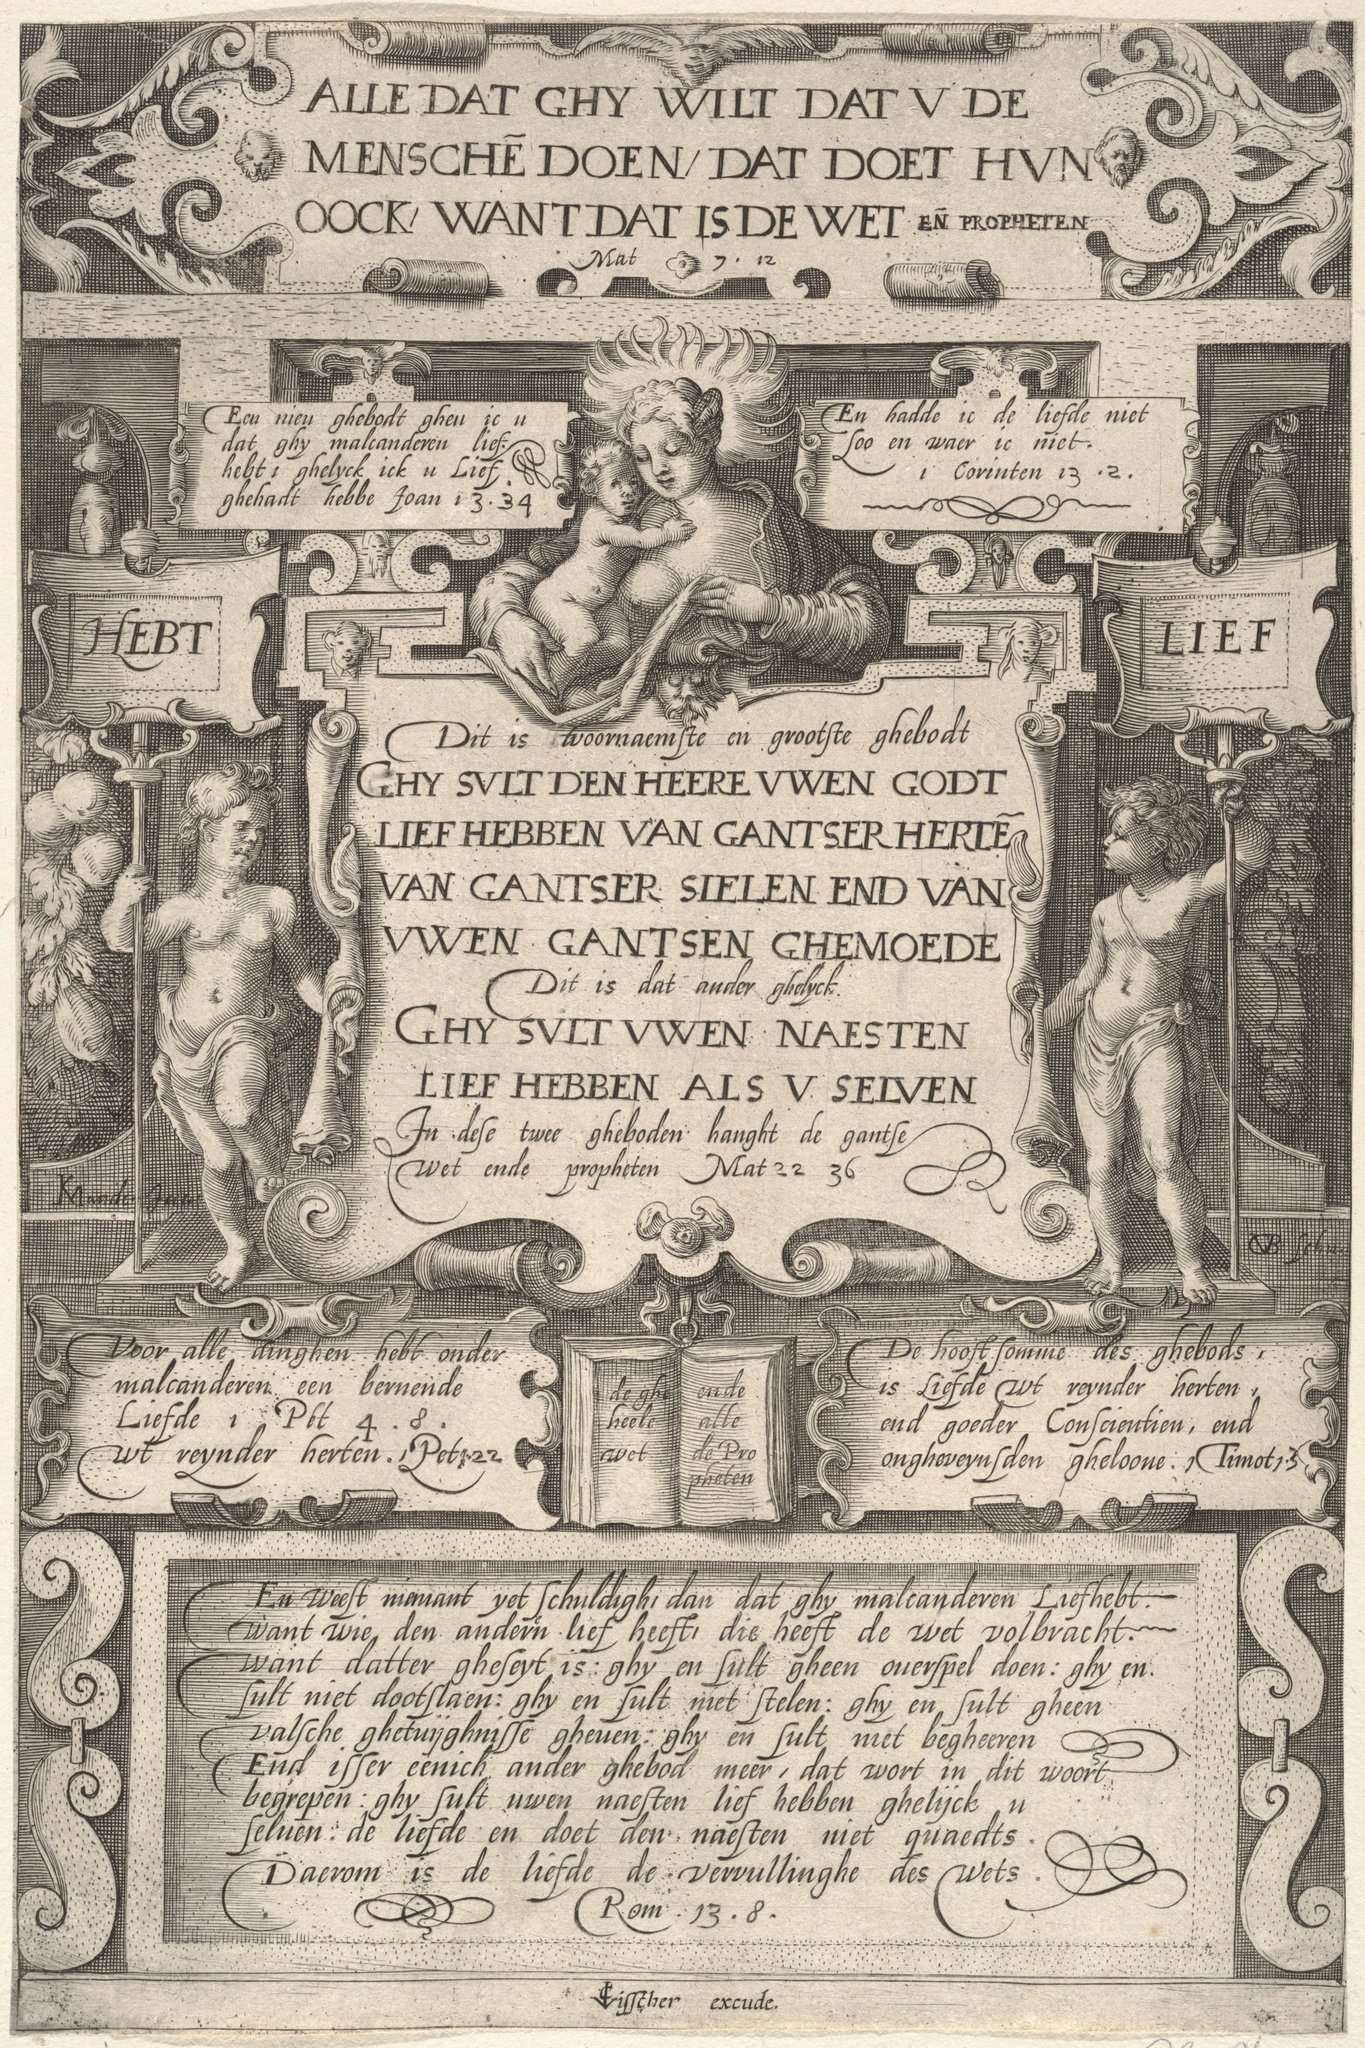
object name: print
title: The Commandment to Love One Another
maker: gillis van breen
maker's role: artist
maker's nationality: netherlandish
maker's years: 1595-1622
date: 1599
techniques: engraving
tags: madonna and child